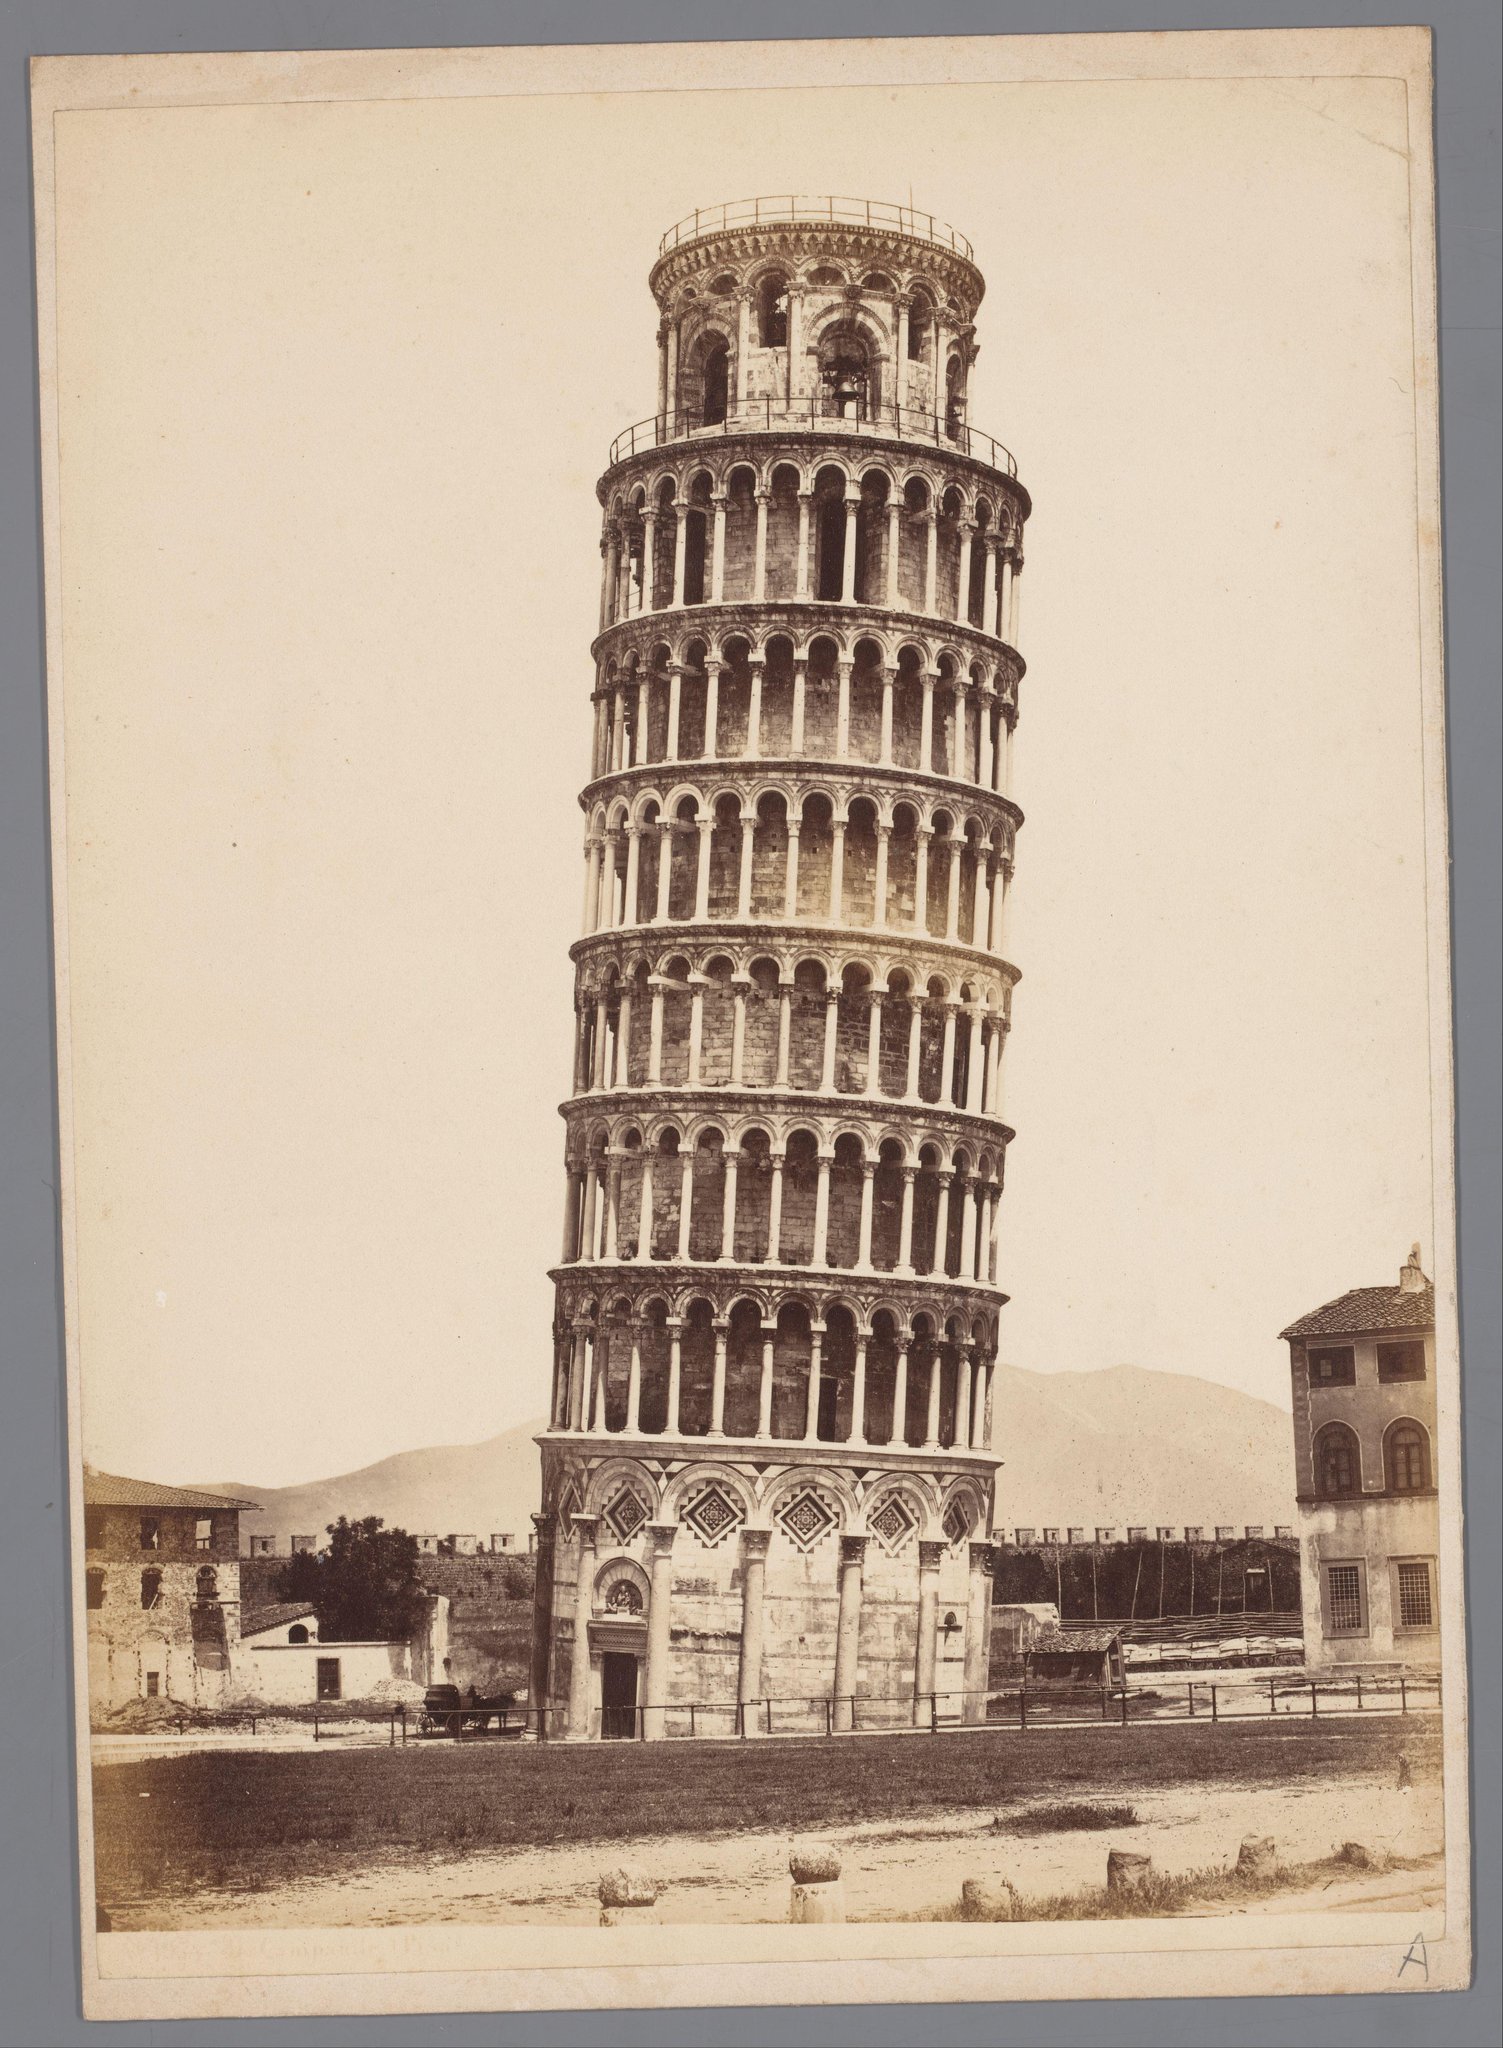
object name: photograph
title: Toren van Pisa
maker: giorgio sommer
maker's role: fotograaf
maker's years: 1834-1914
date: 1857-1914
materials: cardboard, paper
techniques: albumen print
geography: pisa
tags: parts of church exterior and annexes: campanile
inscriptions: inscription: ‘A’, inscription: ‘Sommer (t)’